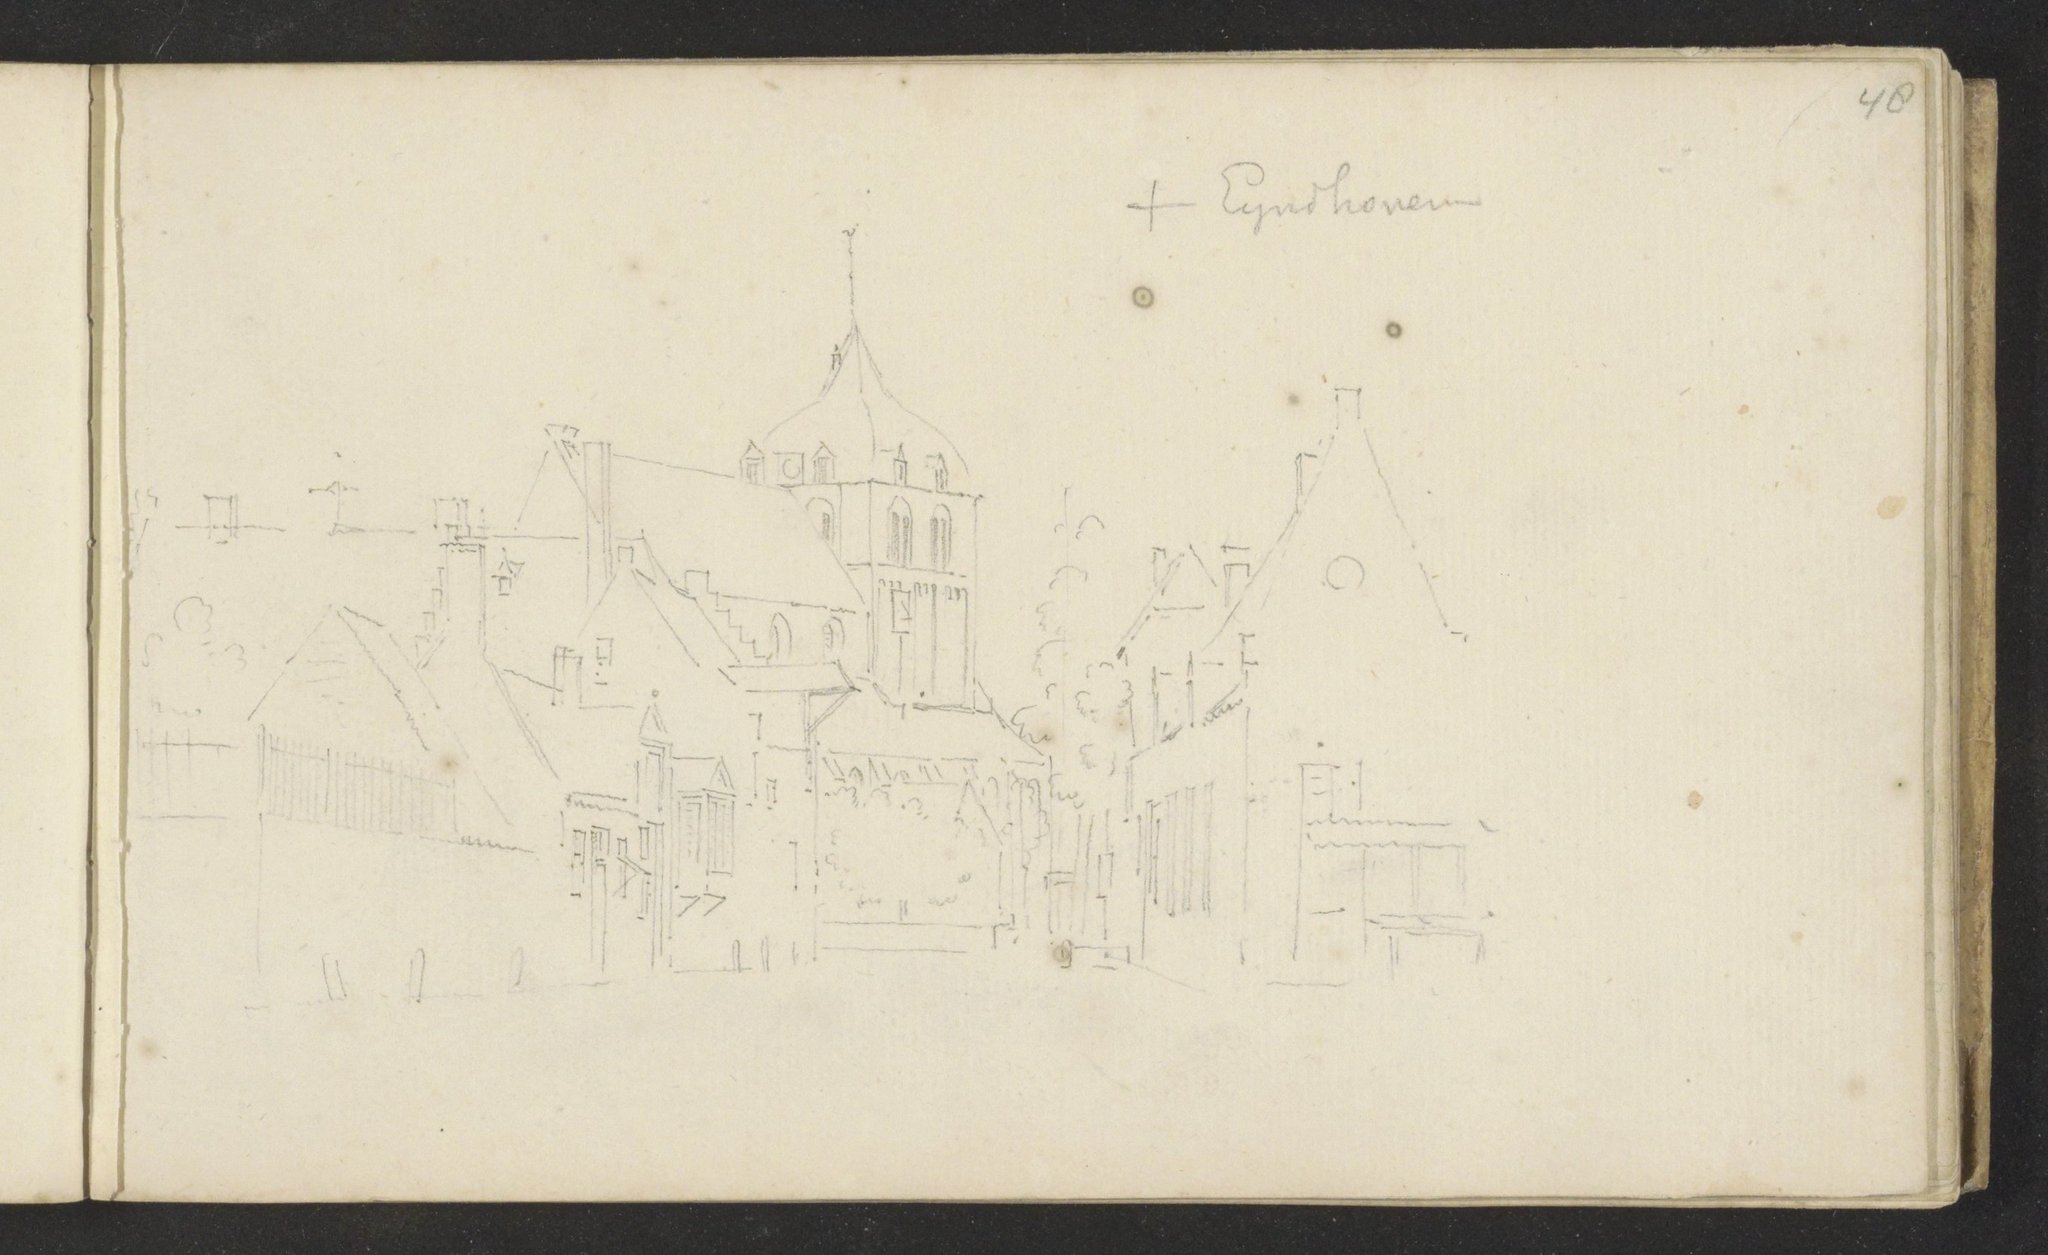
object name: sketchbook leaf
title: Gezicht te Eindhoven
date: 1701-1759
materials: paper, pencil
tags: prospect of village, silhouette of village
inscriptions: annotation: ‘+ Eyndhoven’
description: Blad 48 recto uit een schetsboek met 65 bladen.